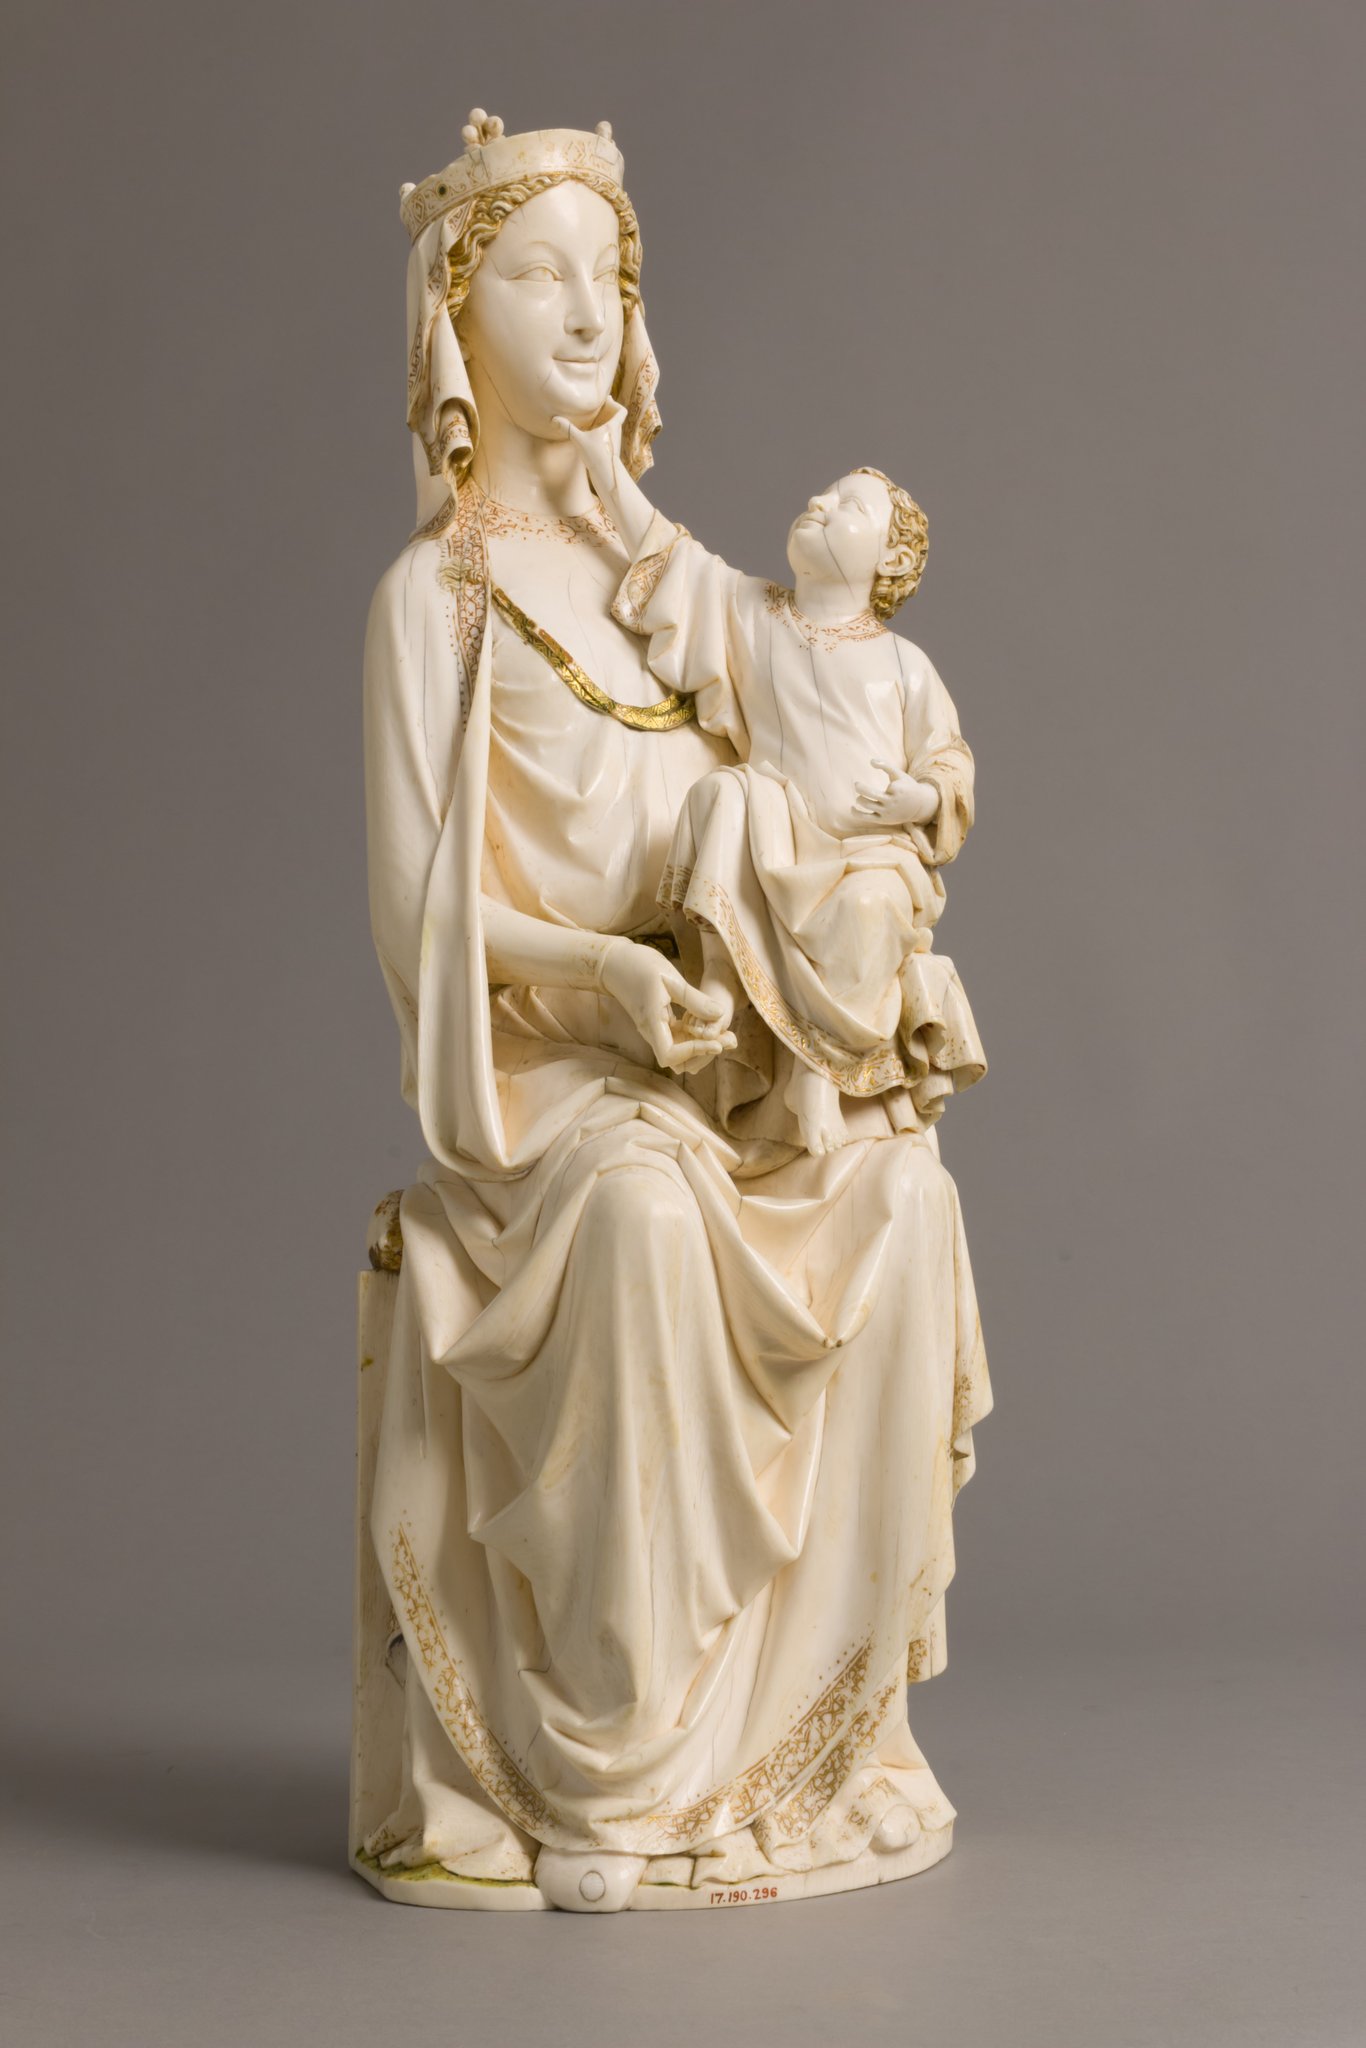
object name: statuette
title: Enthroned Virgin and Child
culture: french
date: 1275-1300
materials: ivory, paint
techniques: gilding